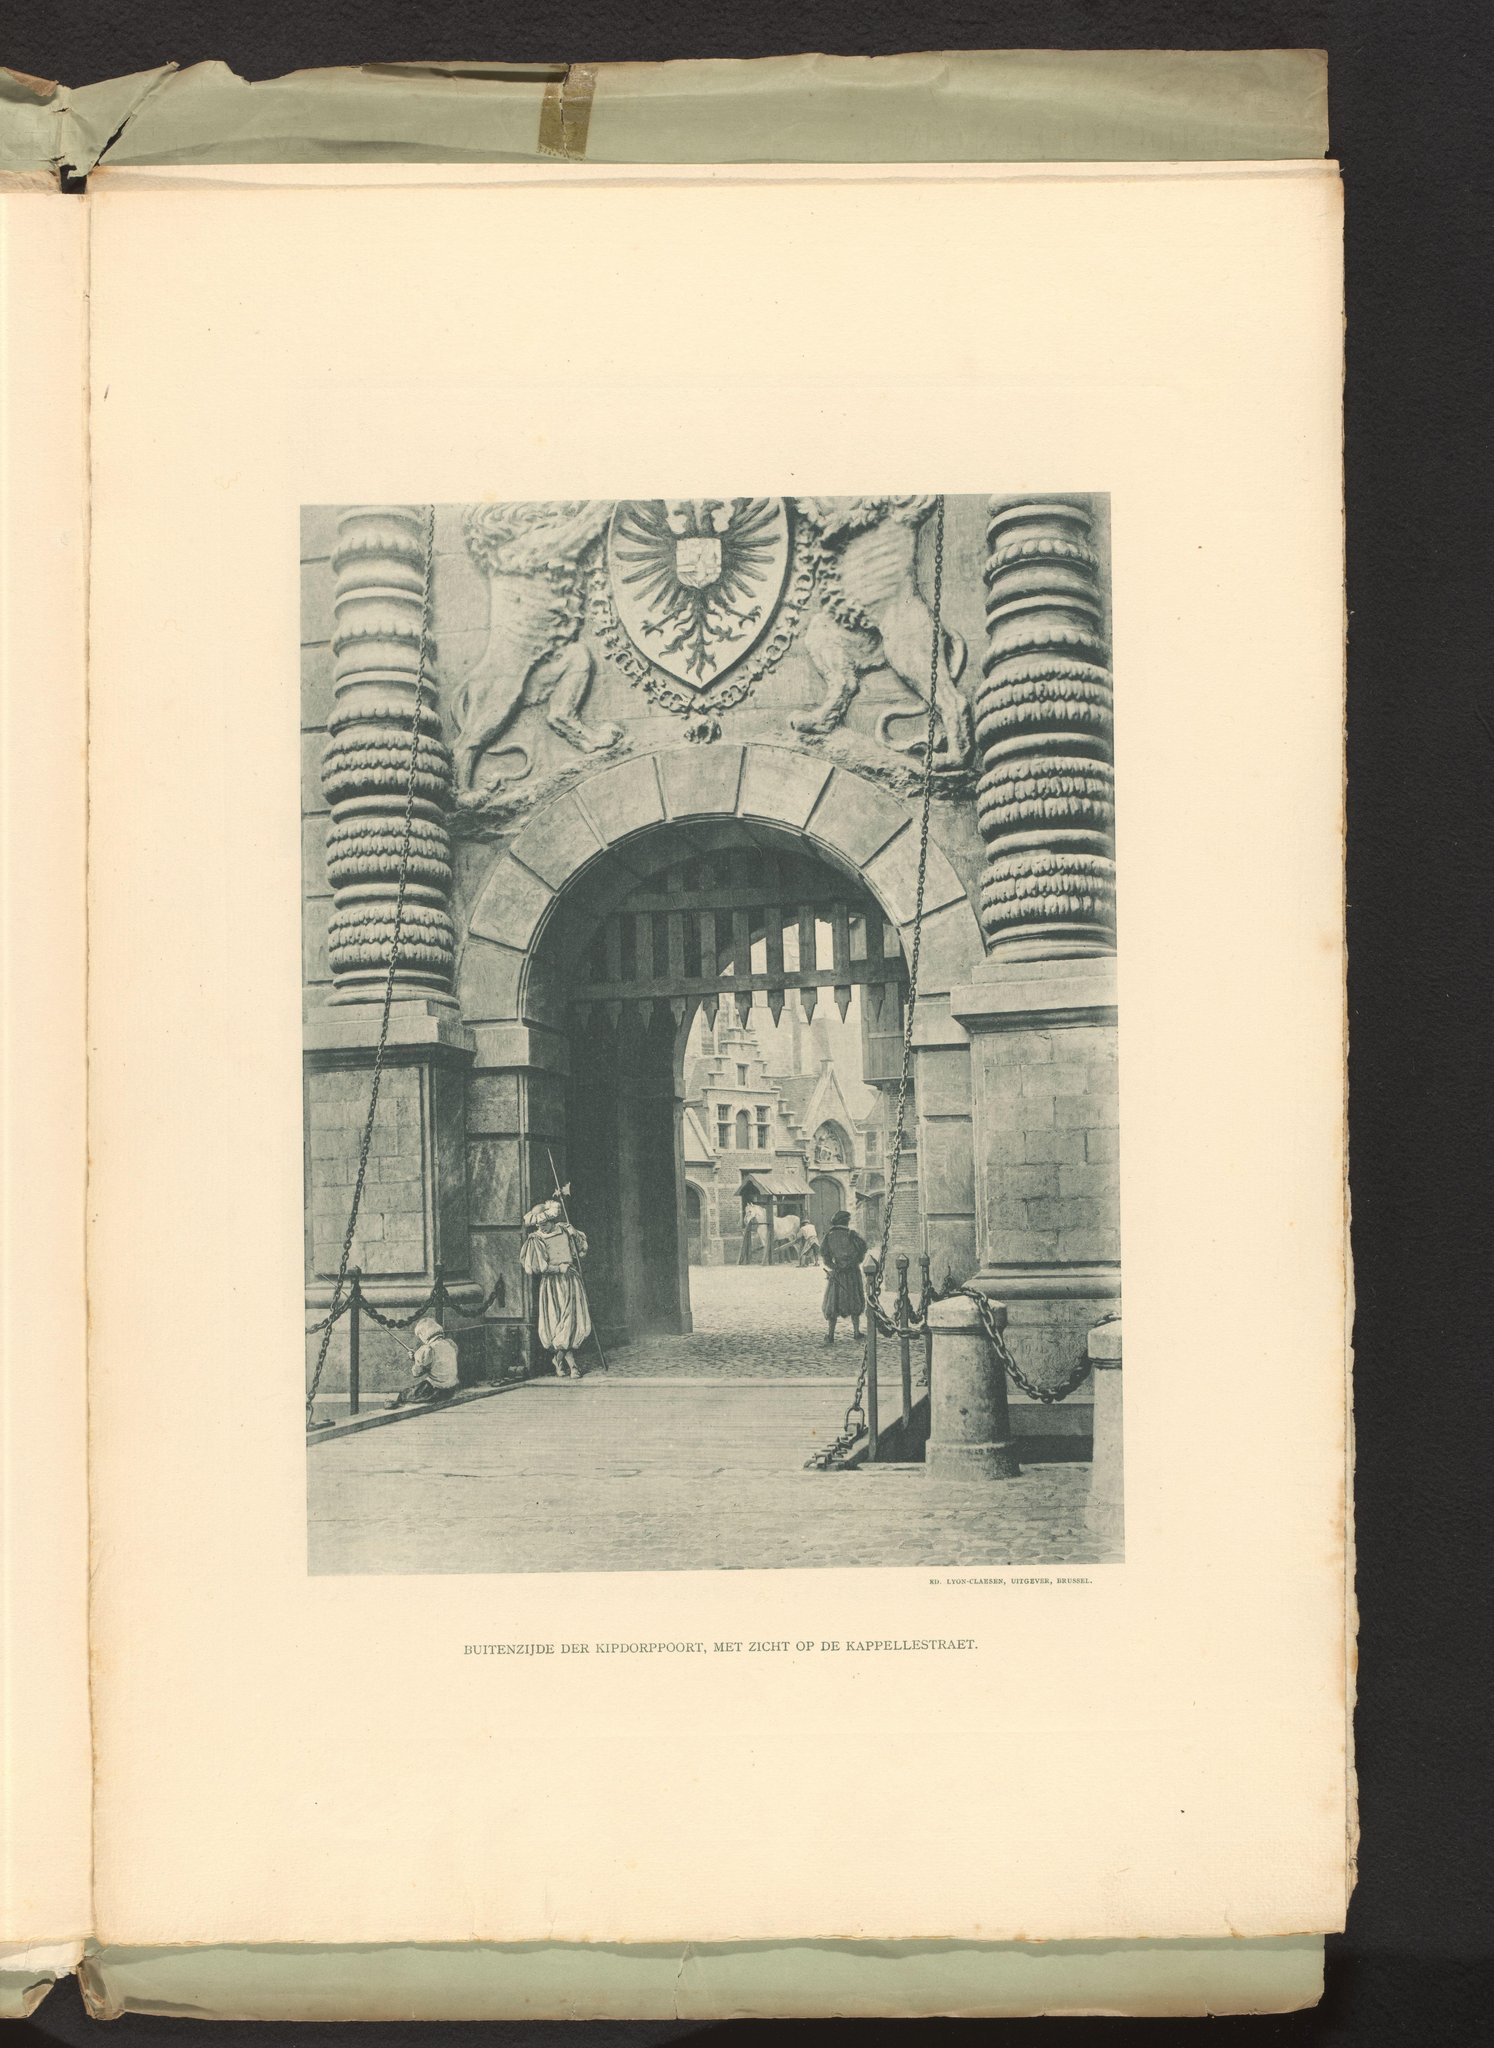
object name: photomechanical print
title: Buitenzijde der Kipdorppoort, met zicht op de Kappellestraet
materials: paper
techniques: photograph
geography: brussels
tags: world fair, world exhibition, city-gate, antwerp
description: Prent op los blad tussen pagina 14 en 15.